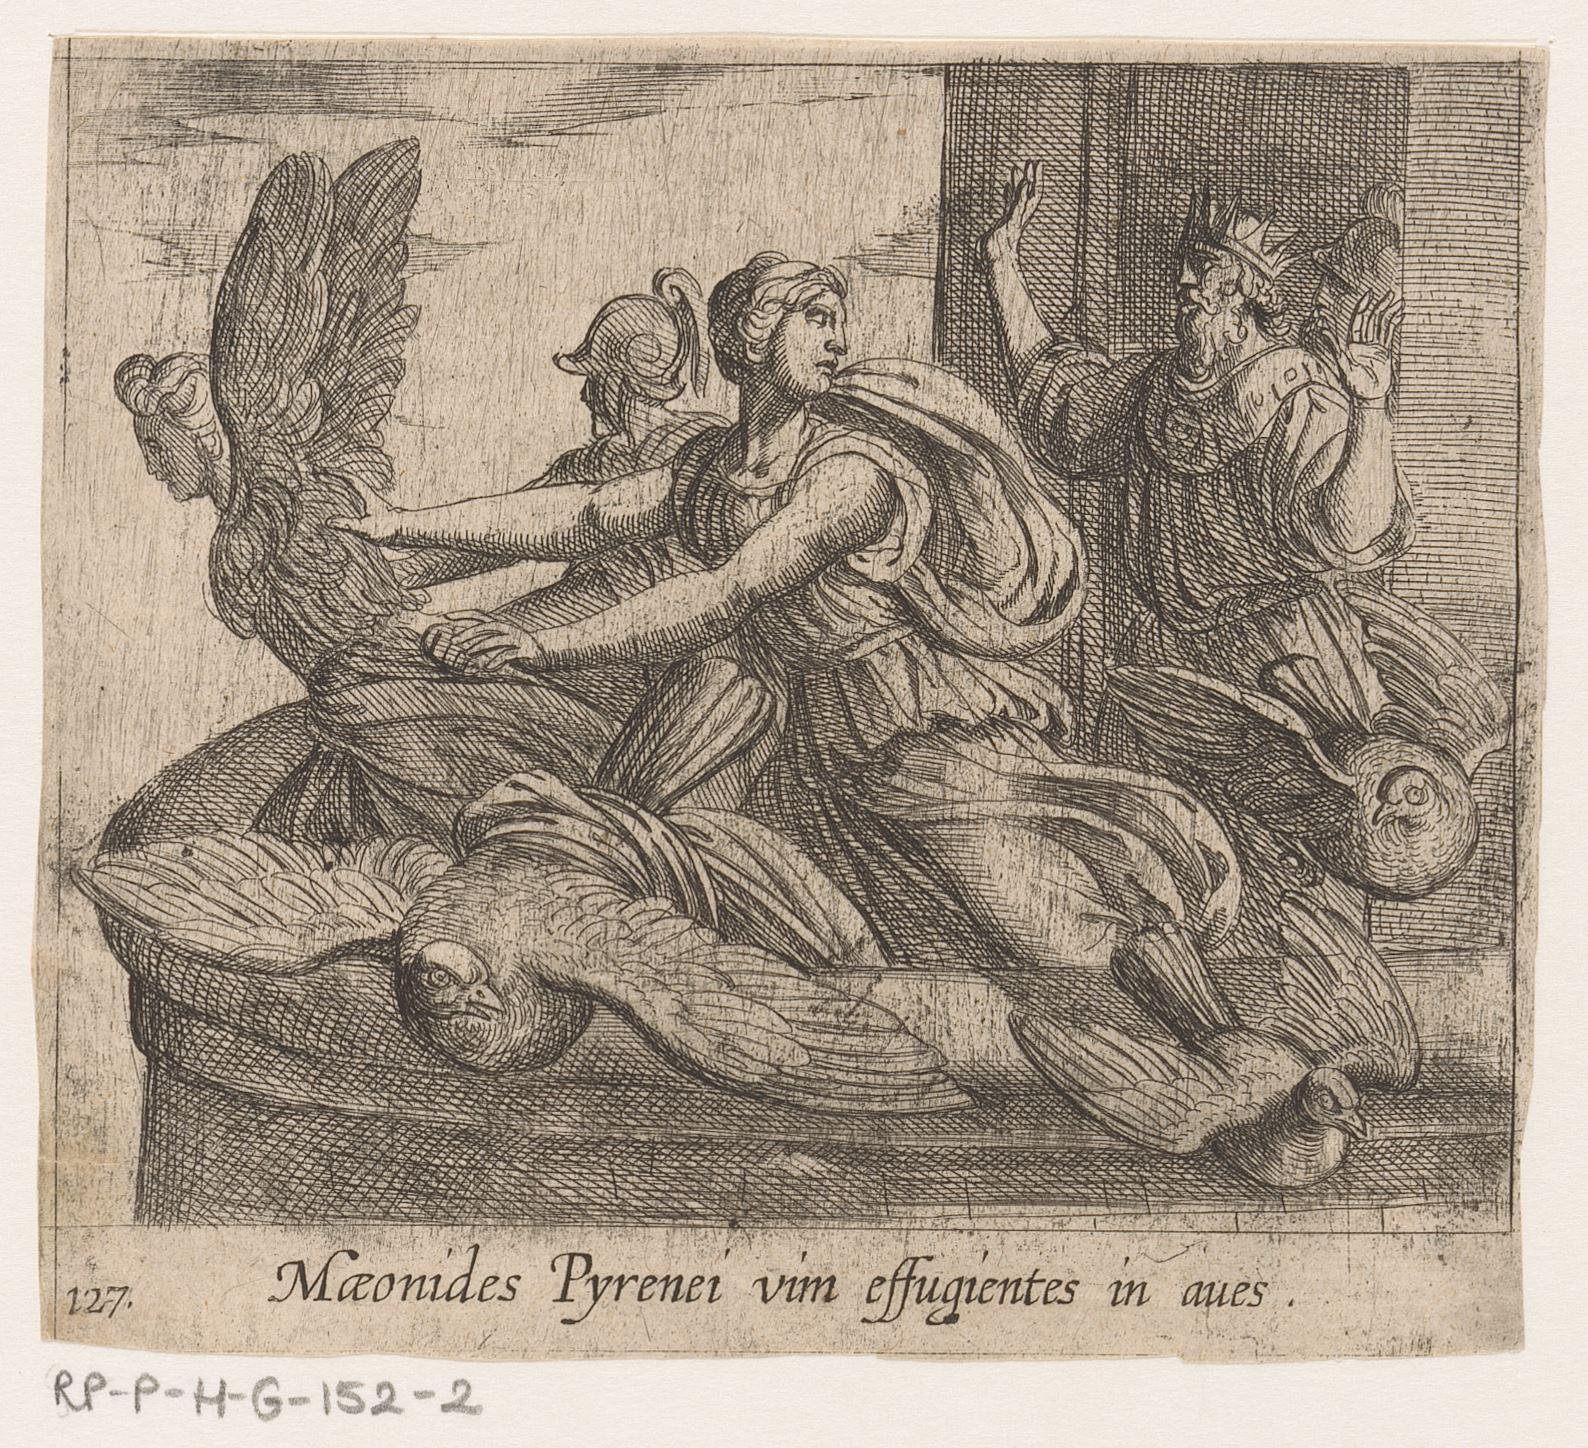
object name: print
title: Maeonides Pyrenei vim effugientes in aves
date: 1606-1638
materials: paper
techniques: etching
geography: amsterdam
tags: anius' daughters changed into doves: to escape agamemnon, who wishes to carry them with him to troy, anius' daughters are changed into doves by bacchus (ovid, metamorphoses xiii 673)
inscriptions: collector's mark: ‘Hinloopen’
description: De dochters van Anius worden in duiven veranderd, zodat zij kunnen ontsnappen aan Agamemnon. Titel in het Latijn in ondermarge.